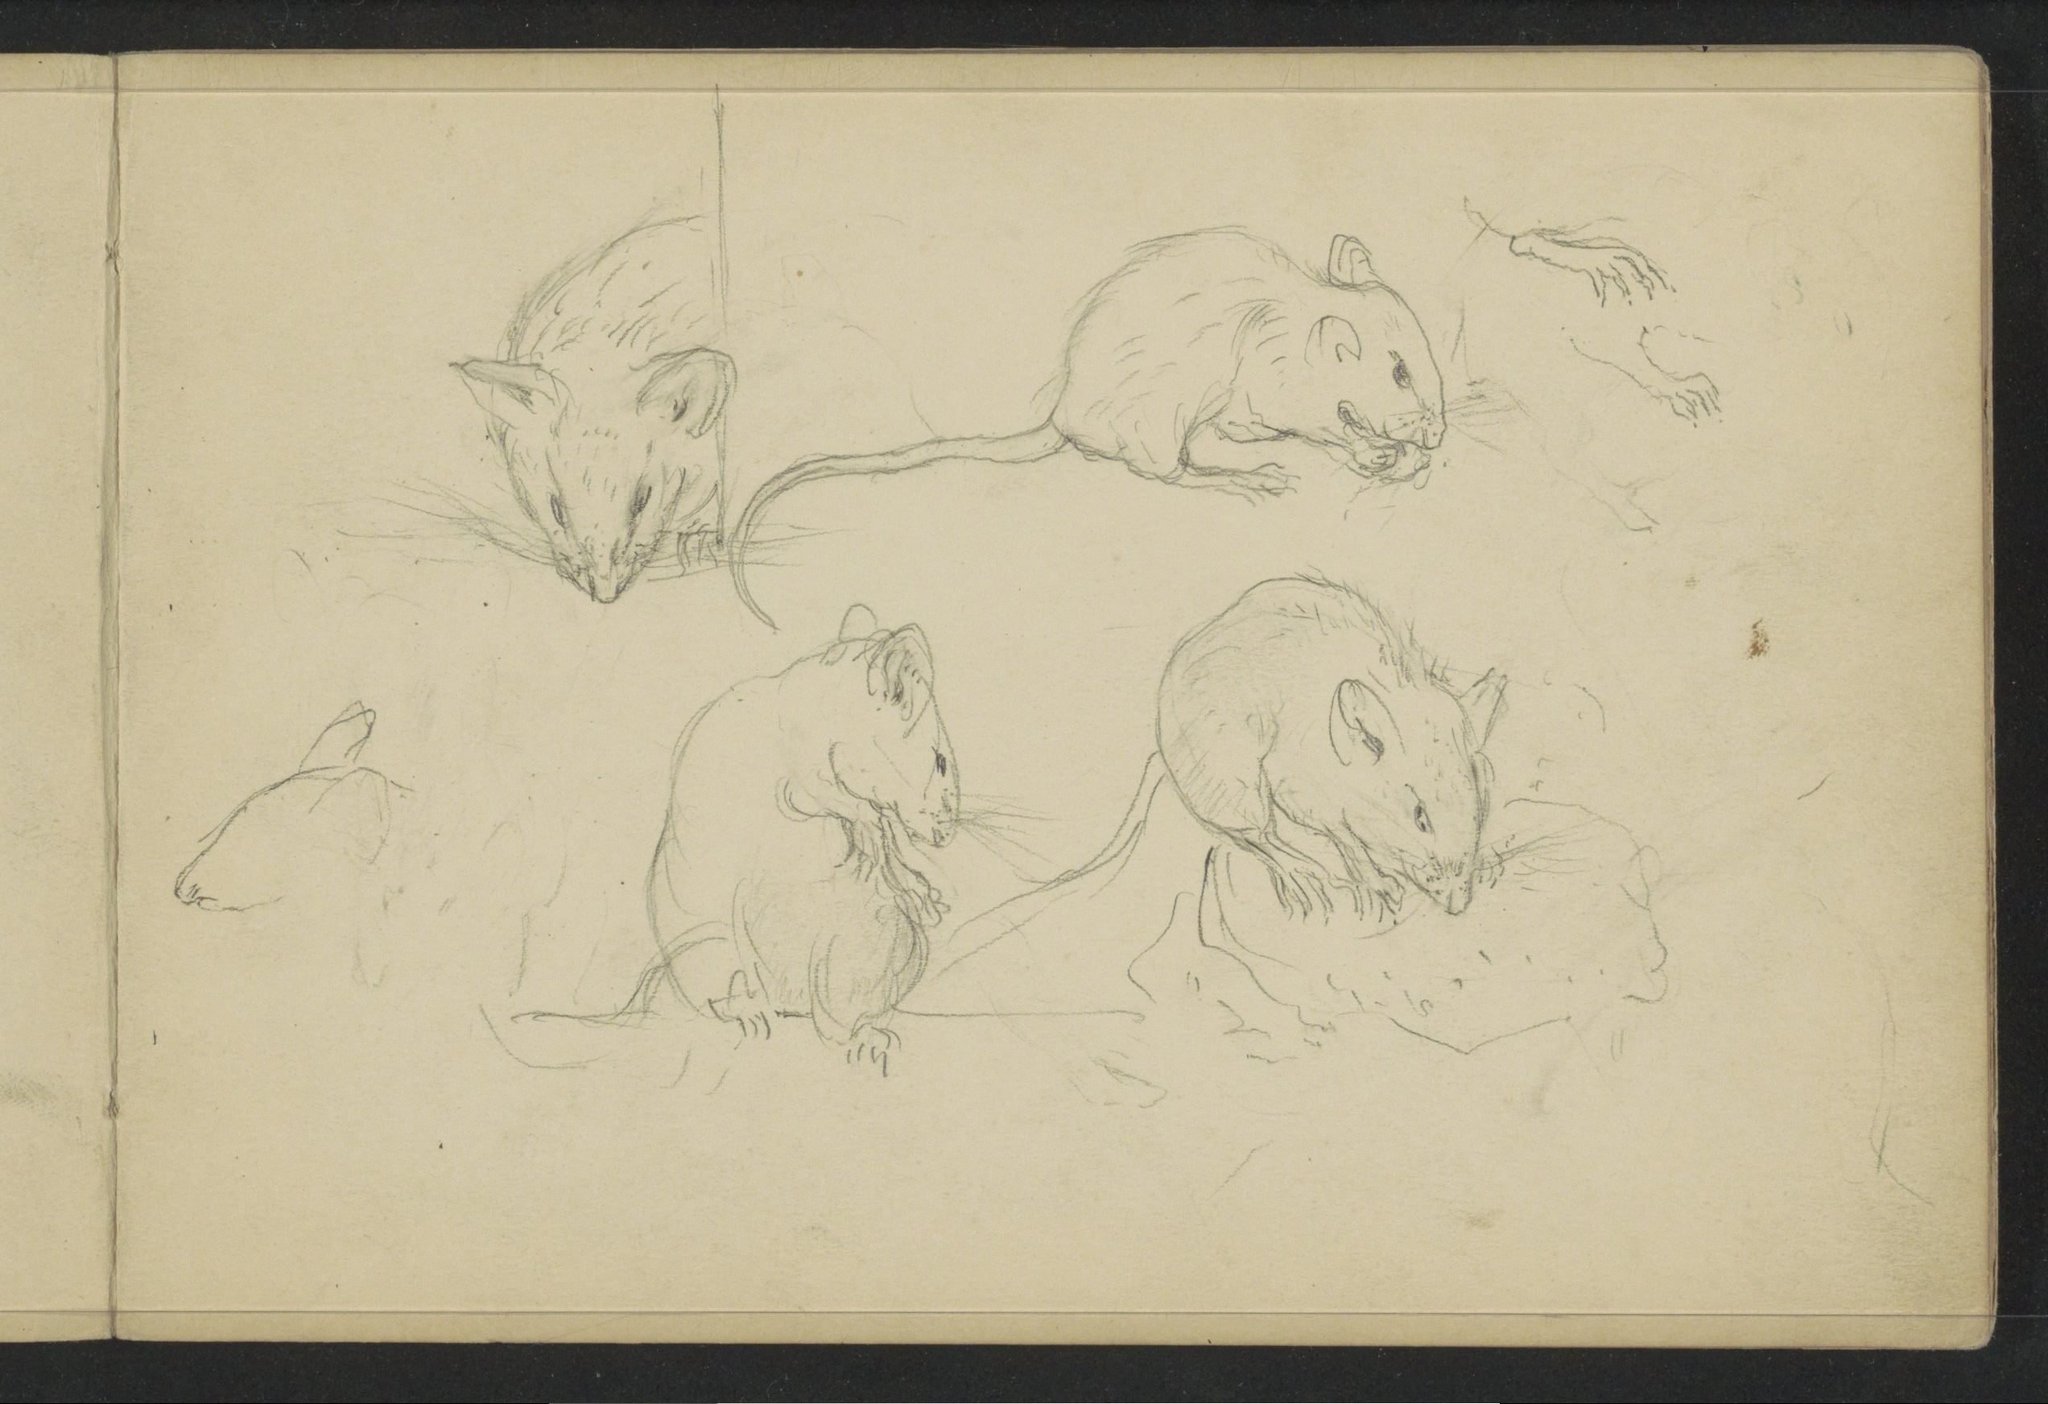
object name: sketchbook leaf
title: Muizen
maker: johanna van de kamer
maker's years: 1873-1922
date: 1883-1922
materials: paper, pencil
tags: rodents: mouse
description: Onder andere muizen die aan een stuk voedsel knagen. Blad 3 recto uit een schetsboek met 13 bladen.